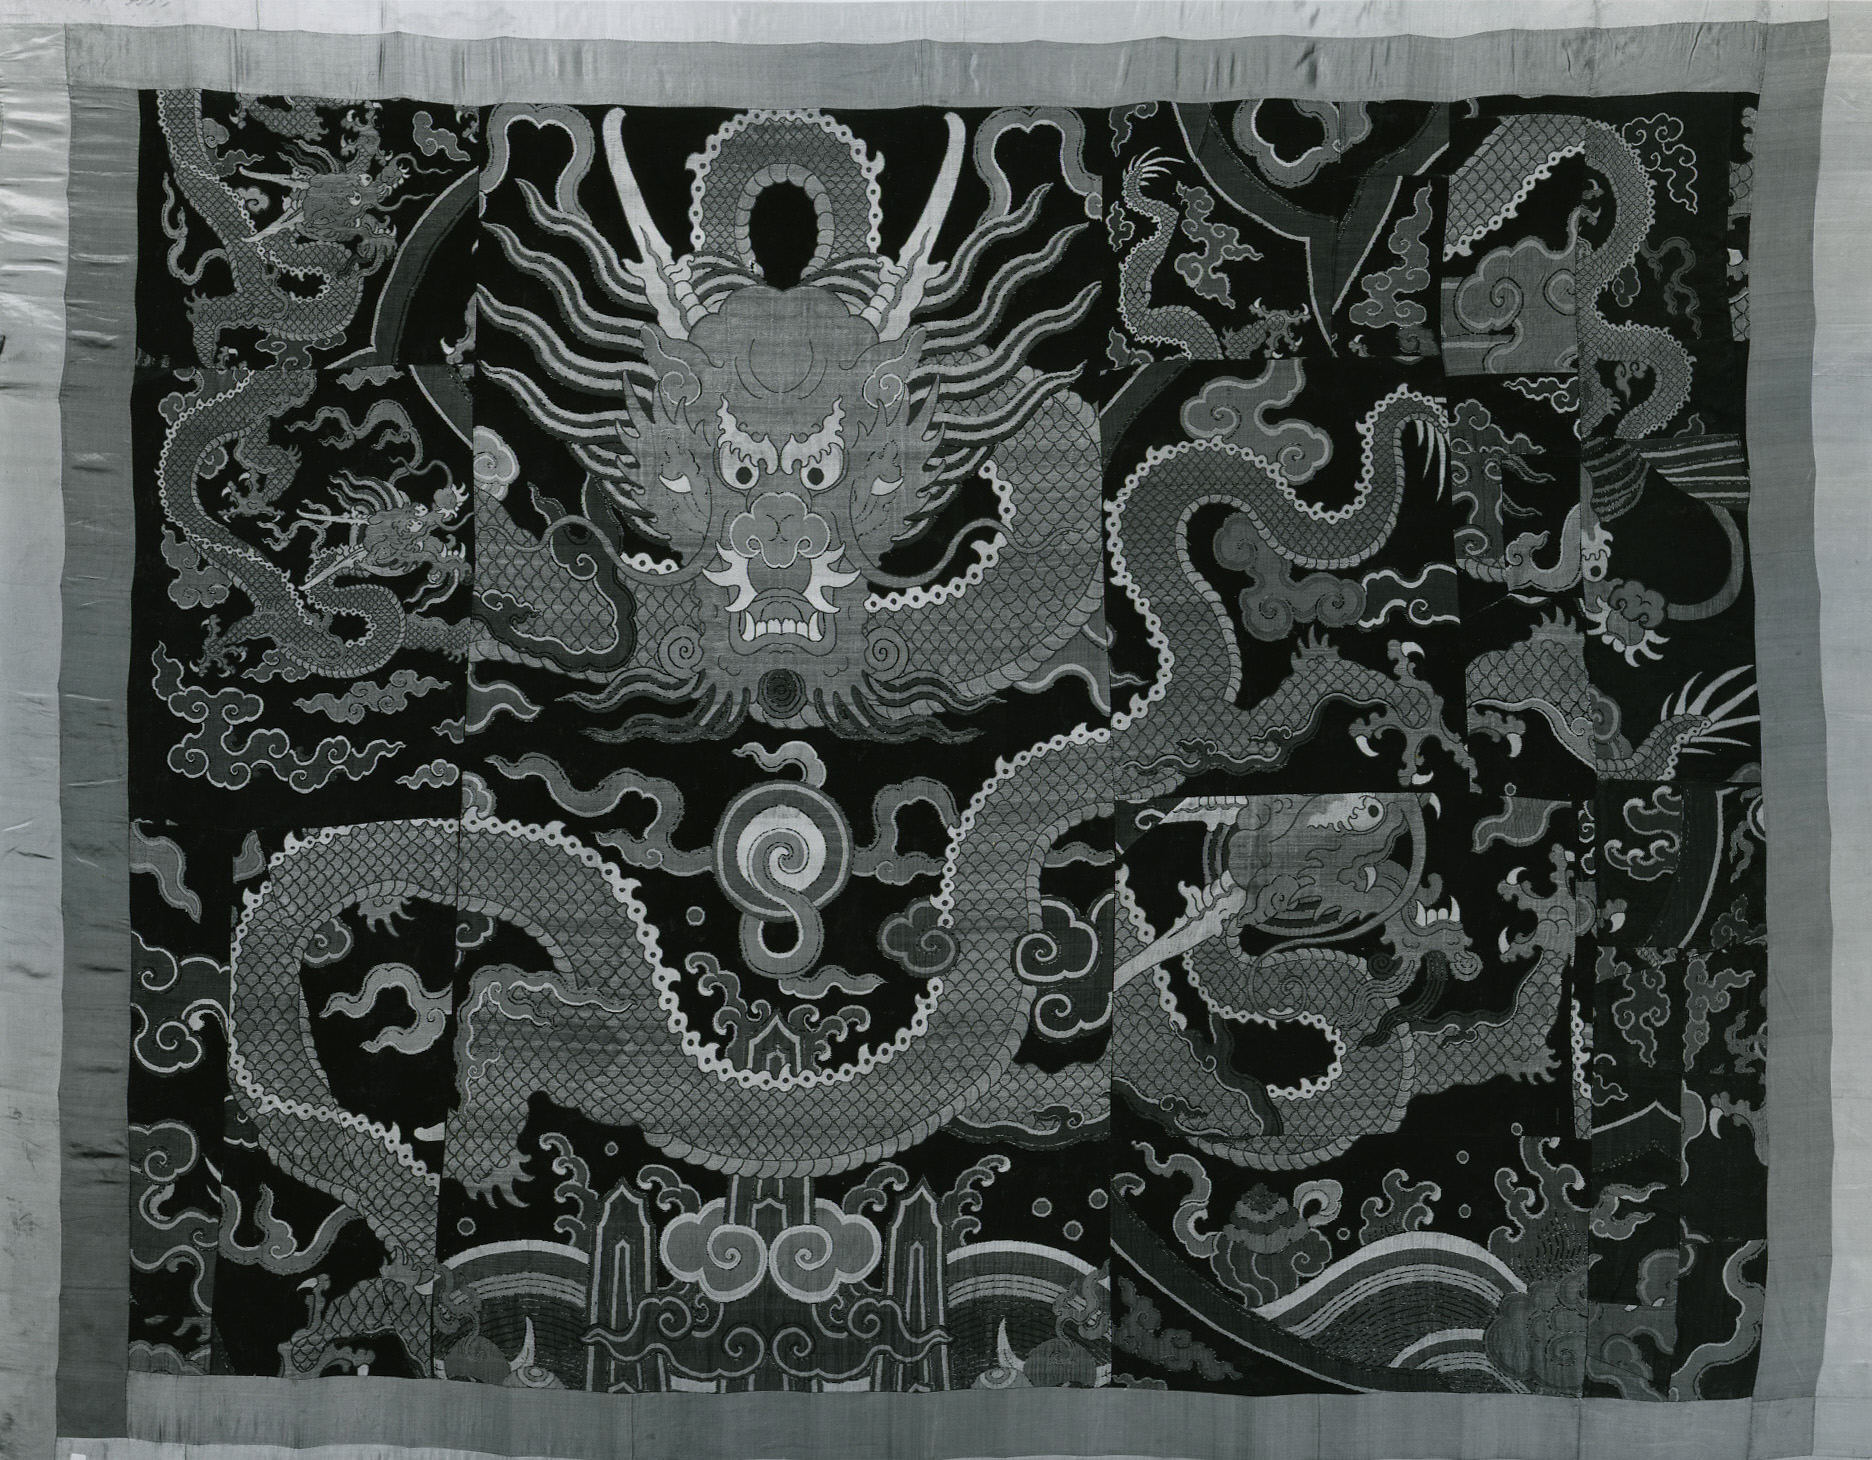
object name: canopy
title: Canopy for Holy Place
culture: chinese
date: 1767-1833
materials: metal thread, silk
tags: dragons